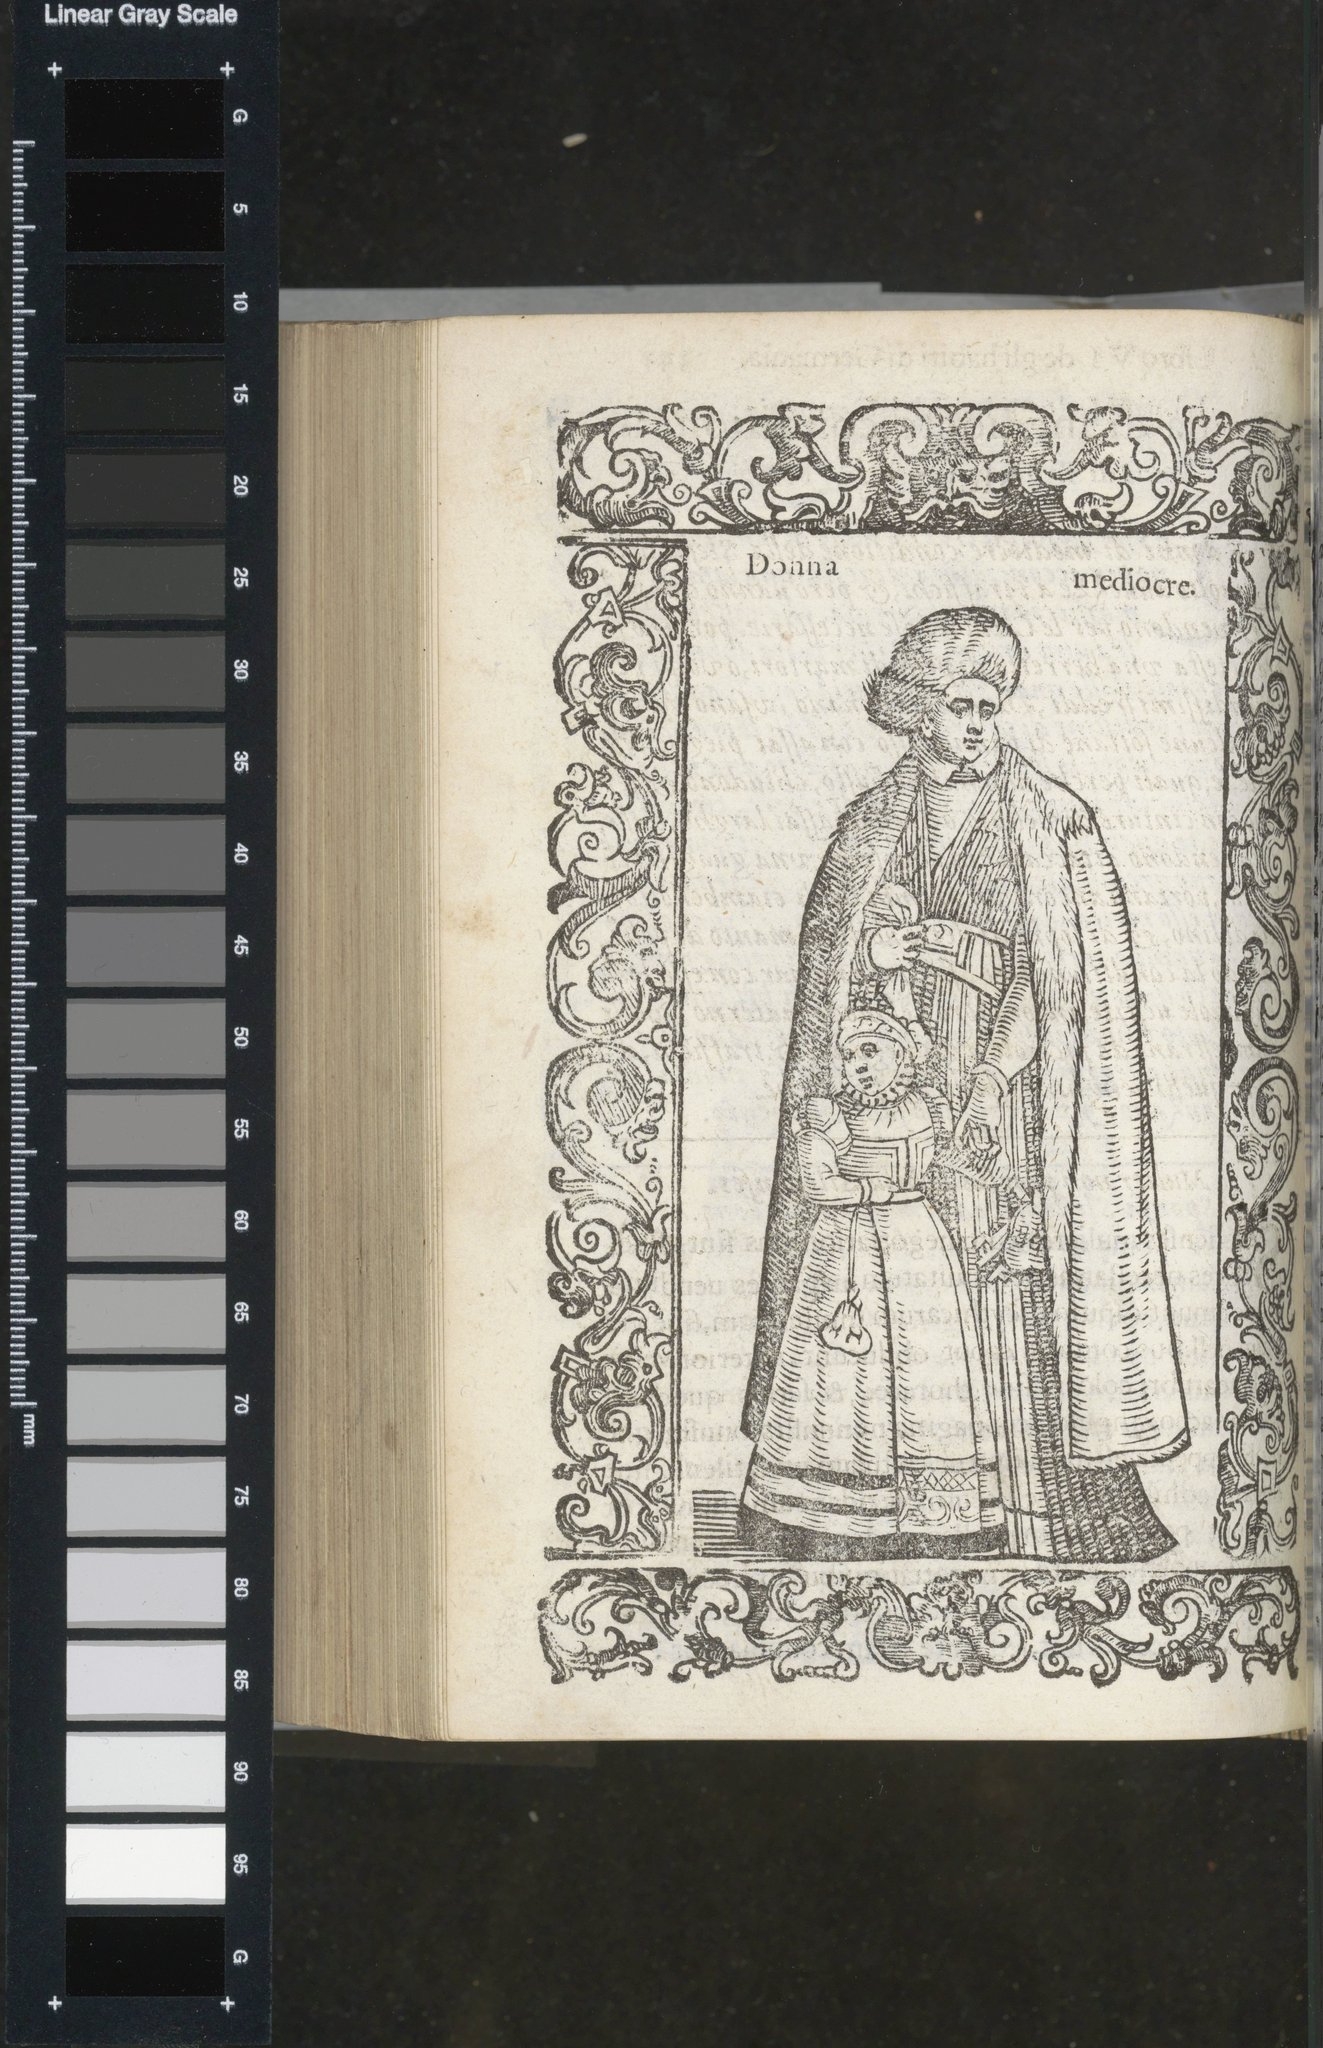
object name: costume print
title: Donna mediocre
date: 1598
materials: paper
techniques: woodcut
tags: fashion plates